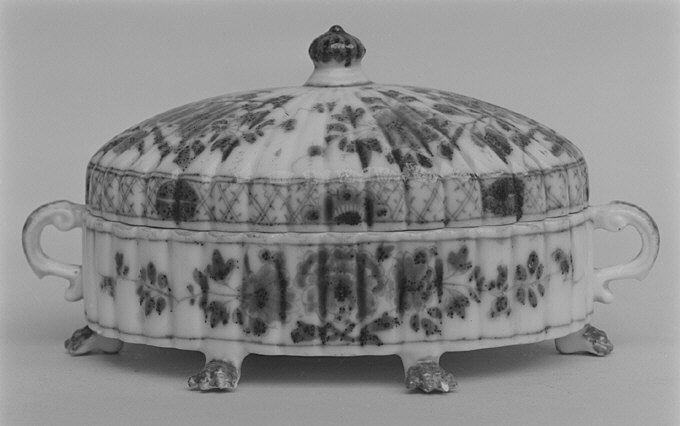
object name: butter dish with cover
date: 1801-1900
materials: hard paste porcelain